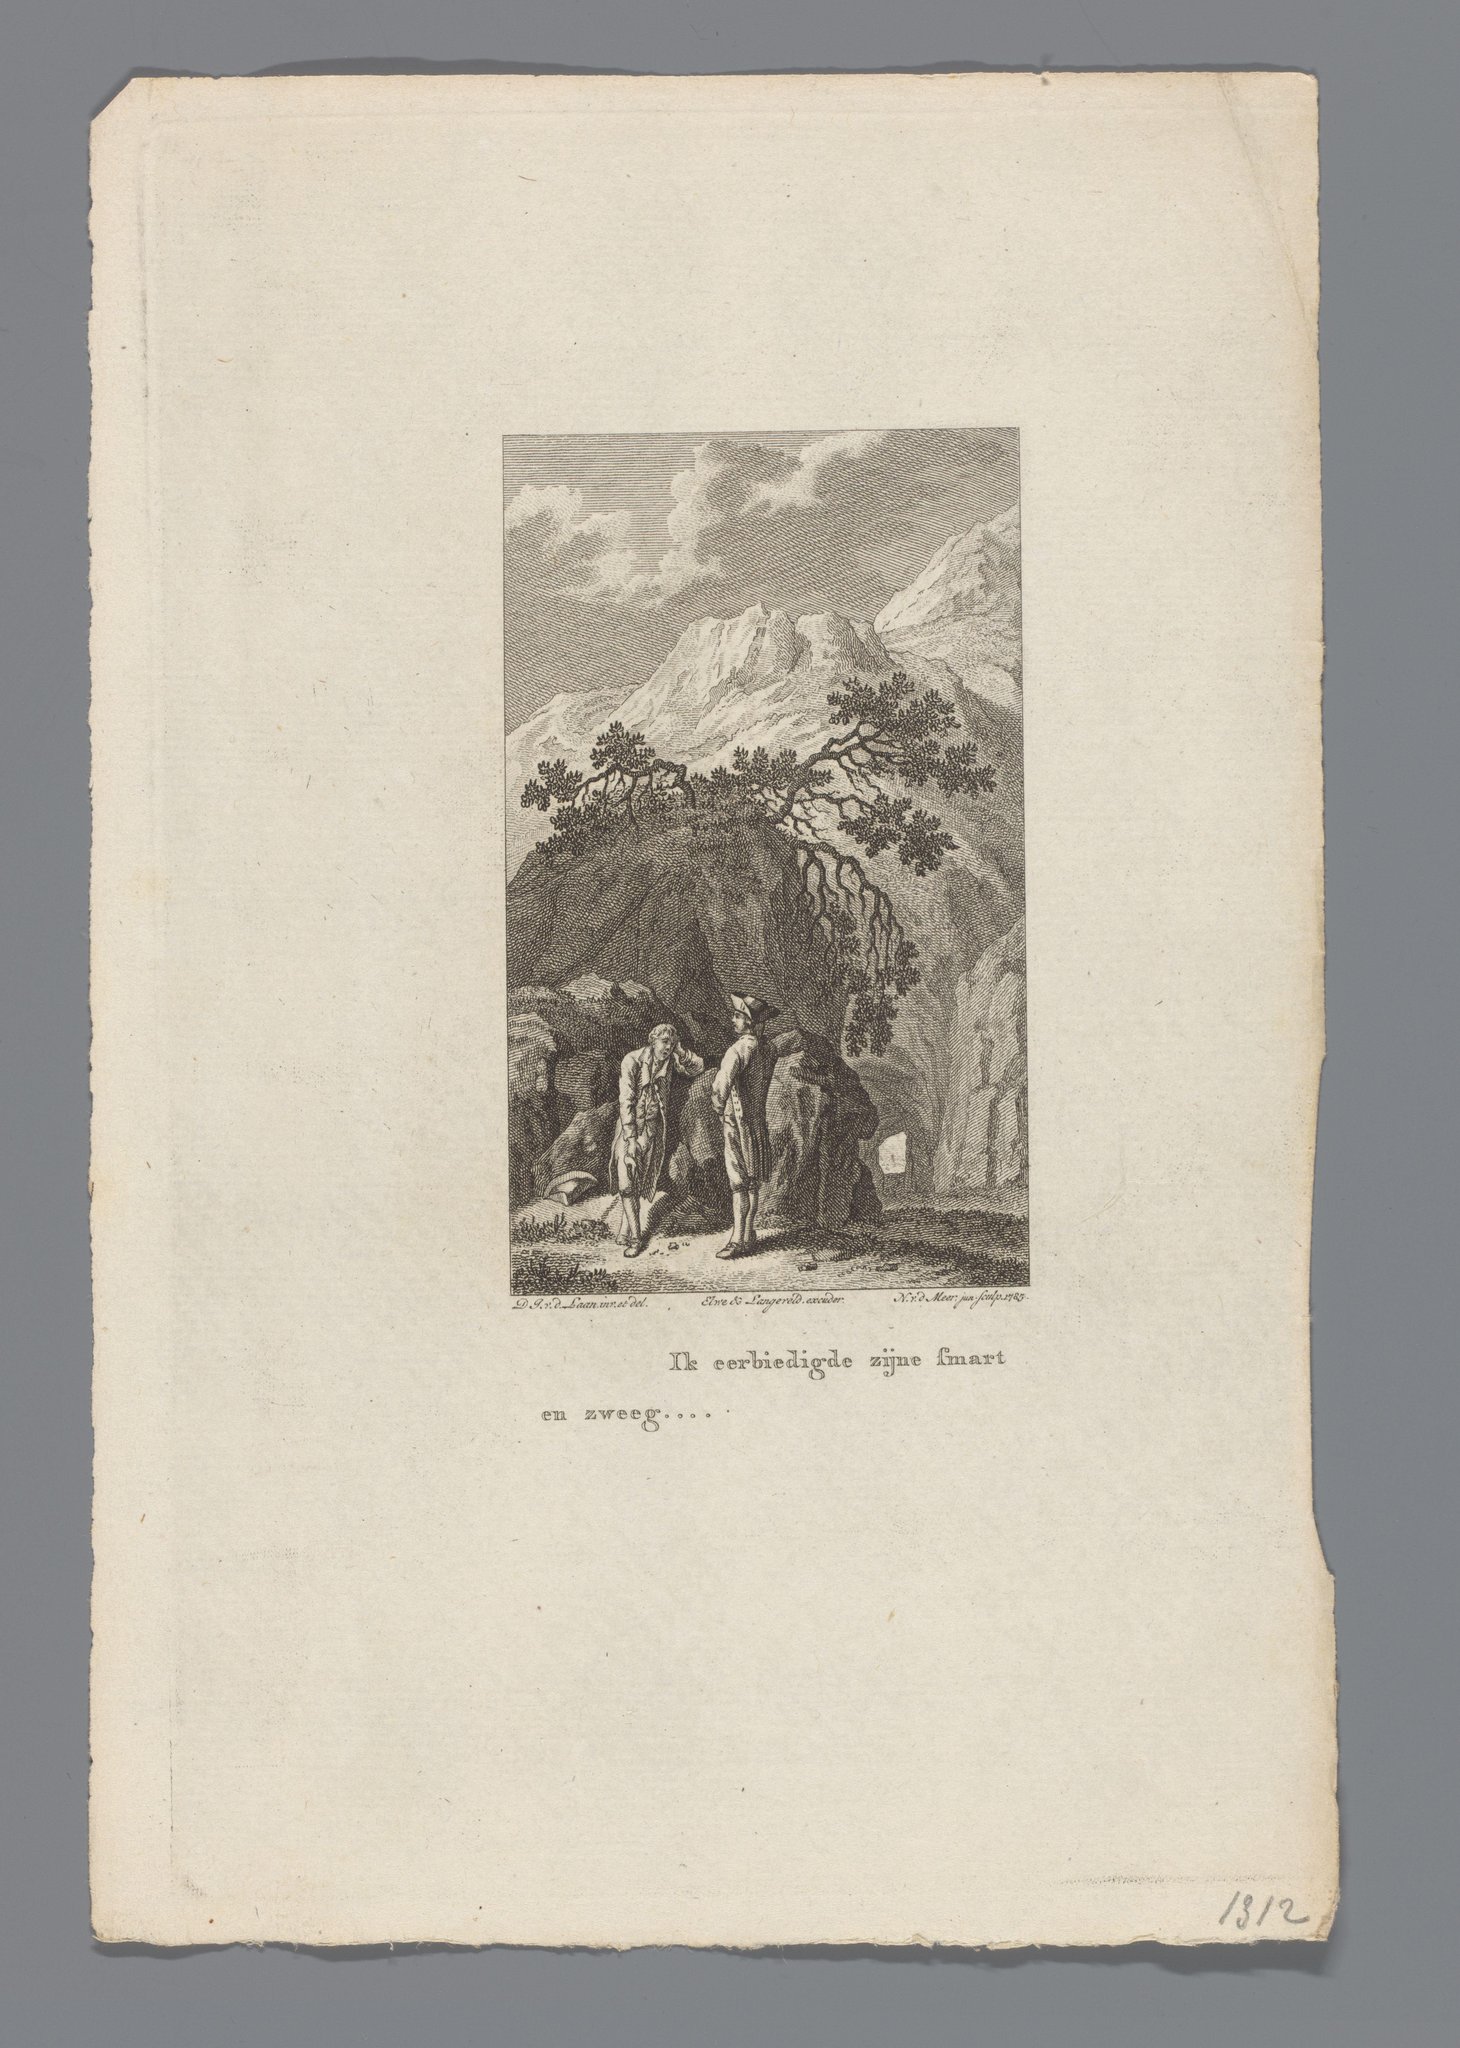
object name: print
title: Ik eerbiedigde zijne smart en zweeg (...).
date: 1785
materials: paper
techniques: etching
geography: amsterdam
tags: speaking, rock-formations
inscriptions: collector's mark: Lugt 2228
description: Prent bij: Feith, Rhĳnvis. Julia. Amsterdam, Jan Barend Elwe and Dirk Meland Langeveld, 1786.